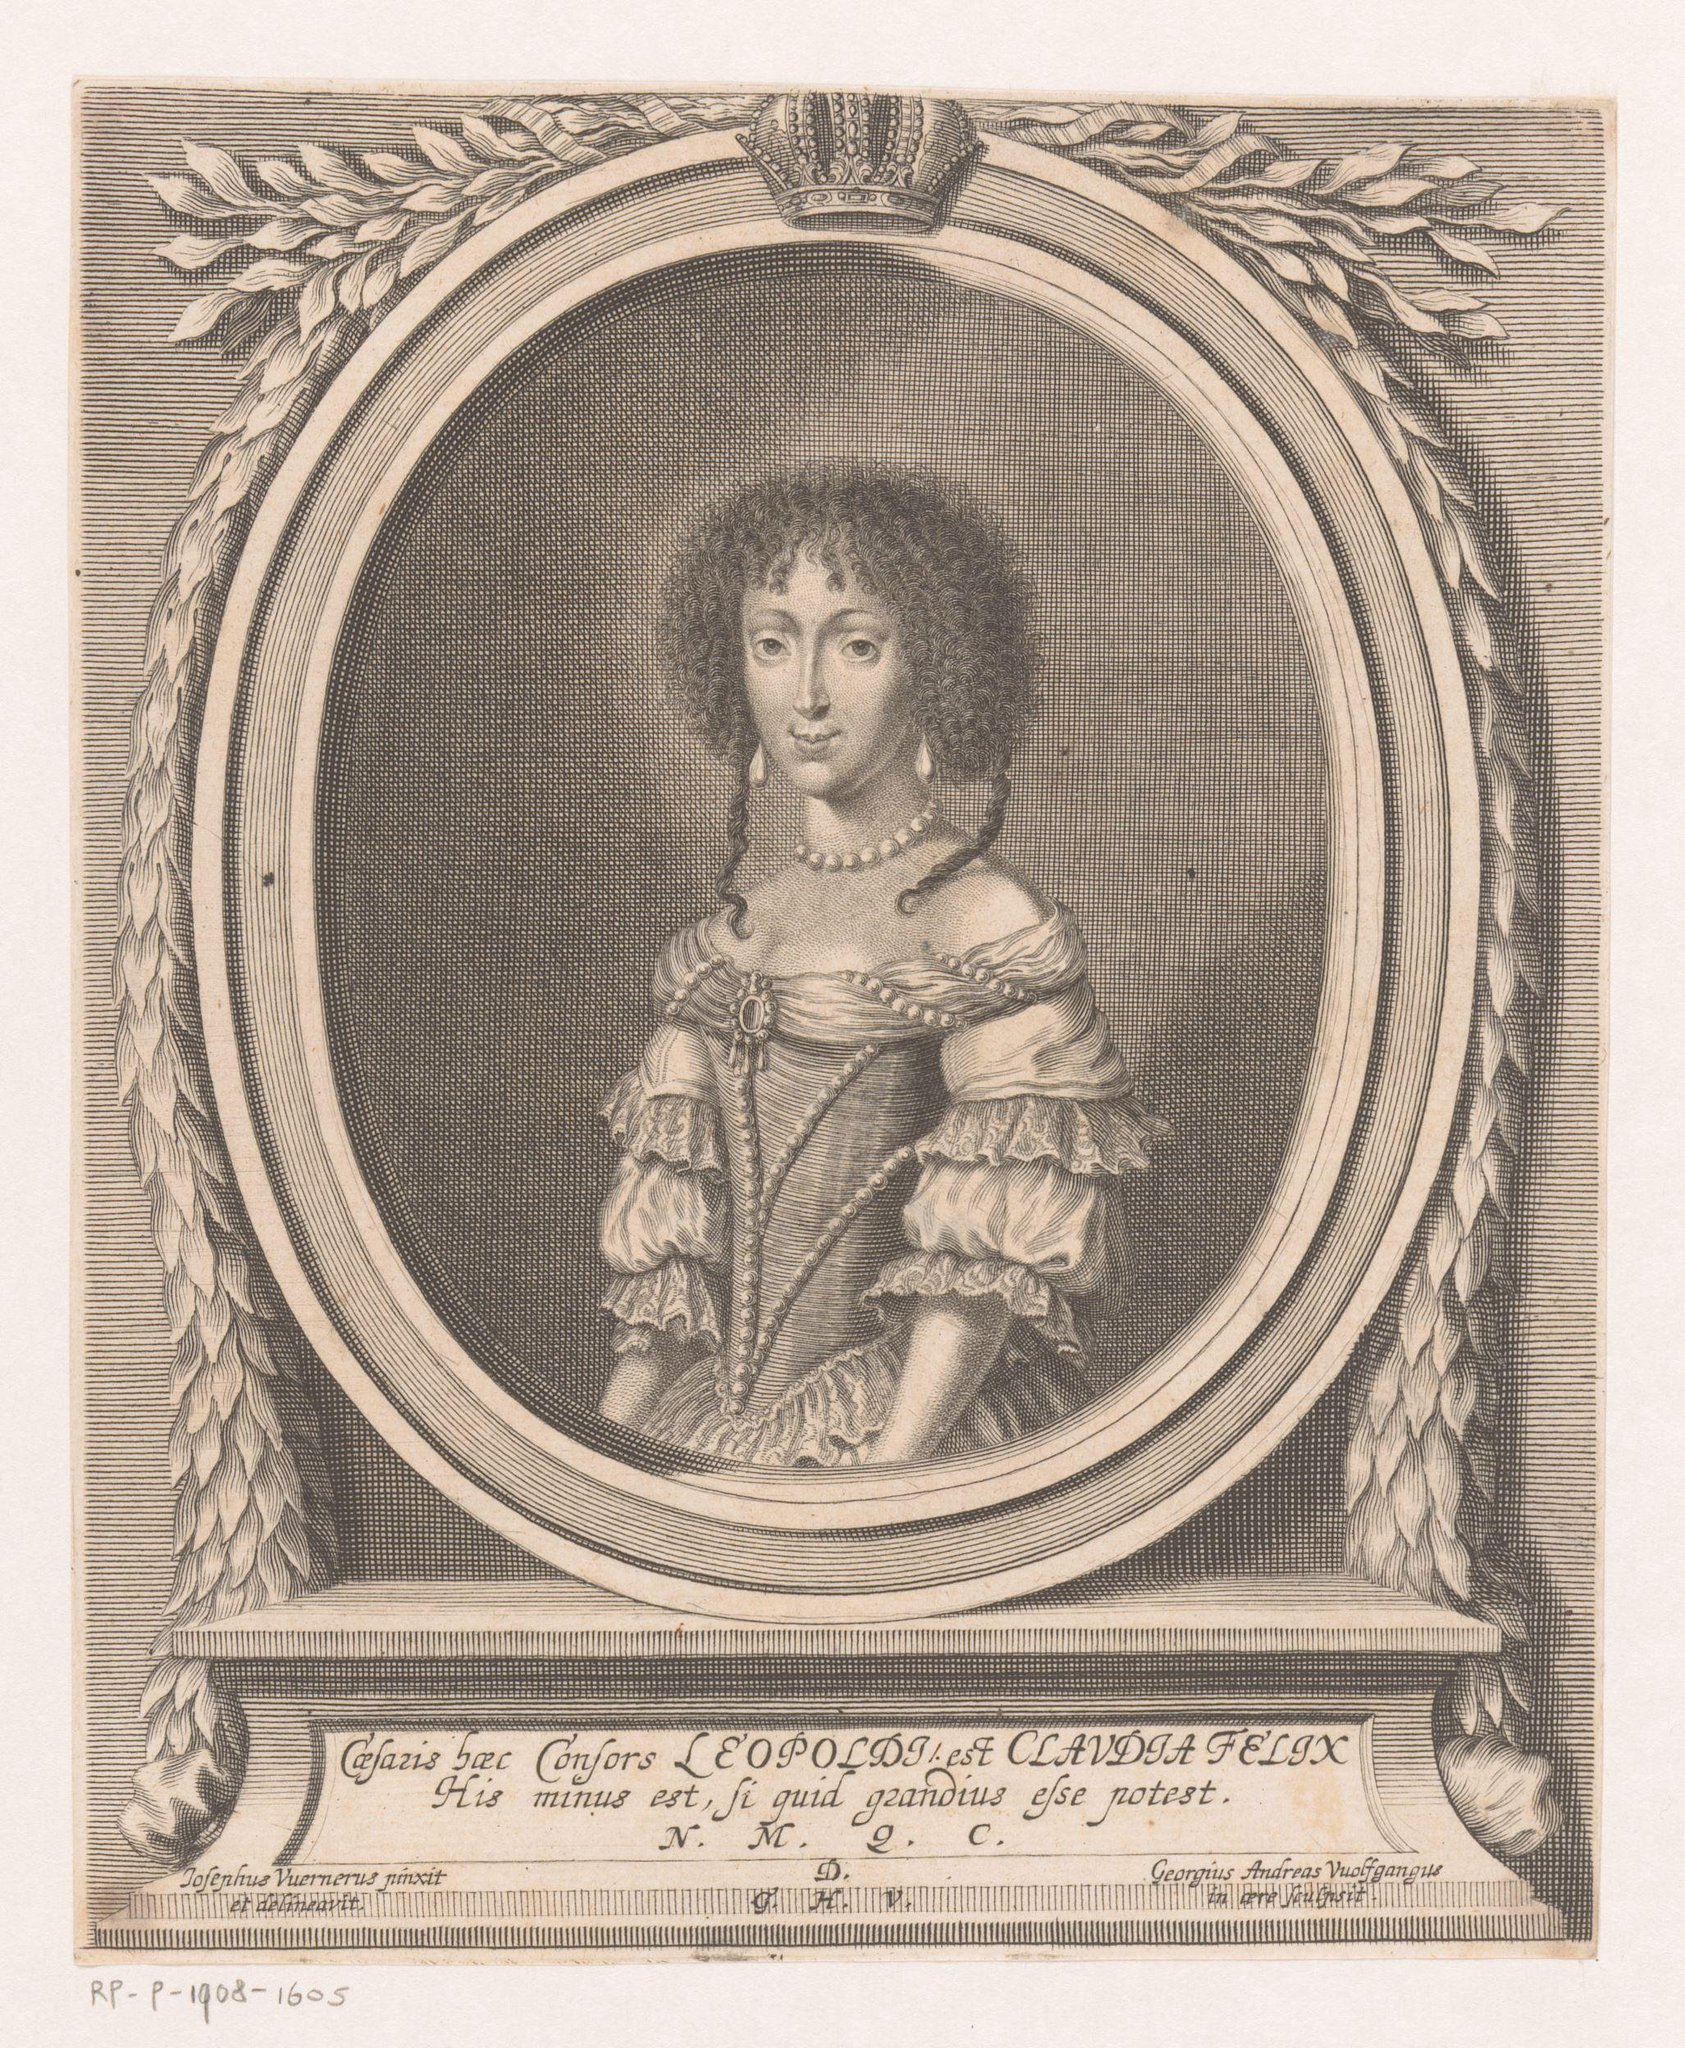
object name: print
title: Portret van Claudia Felizitas, aartshertogin van Oostenrijk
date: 1673-1716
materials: paper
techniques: engraving, etching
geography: germany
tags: vienna, historical persons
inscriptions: collector's mark: Lugt 2228